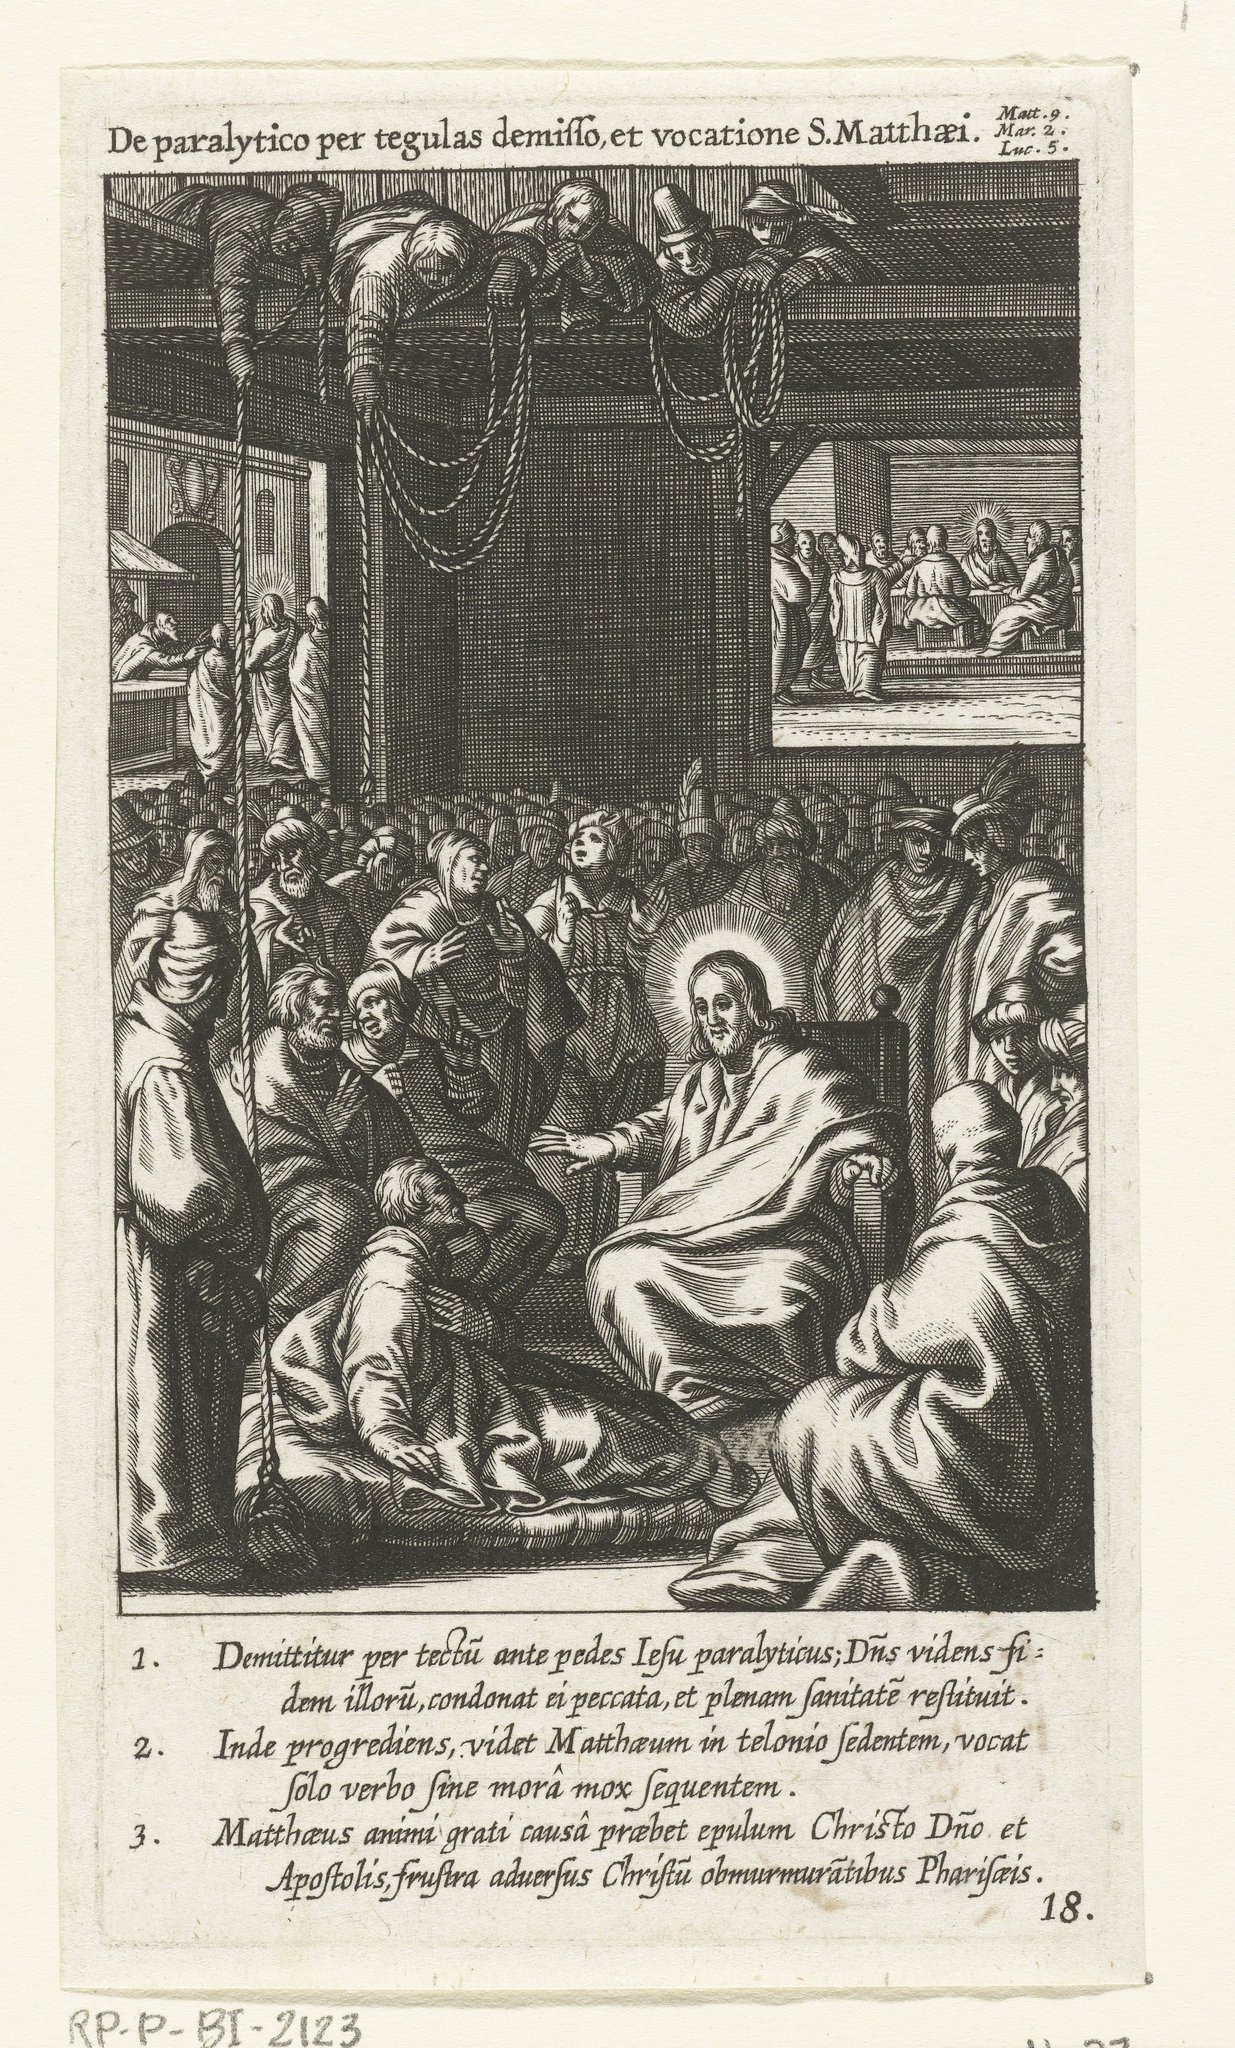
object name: print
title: Christus geneest de kreupele die op zijn bed door het dak naar beneden is gelaten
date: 1590-1622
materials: paper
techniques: engraving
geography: antwerp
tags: christ healing paralytics, disabilities, deformations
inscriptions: collector's mark: Lugt 240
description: Prent uit: Joannes Bourgois, Vitae passionis et mortis Jesu Christi Somini nostri mysteria, Antwerpen Hendrick Aertssens, 1622, afb. 18